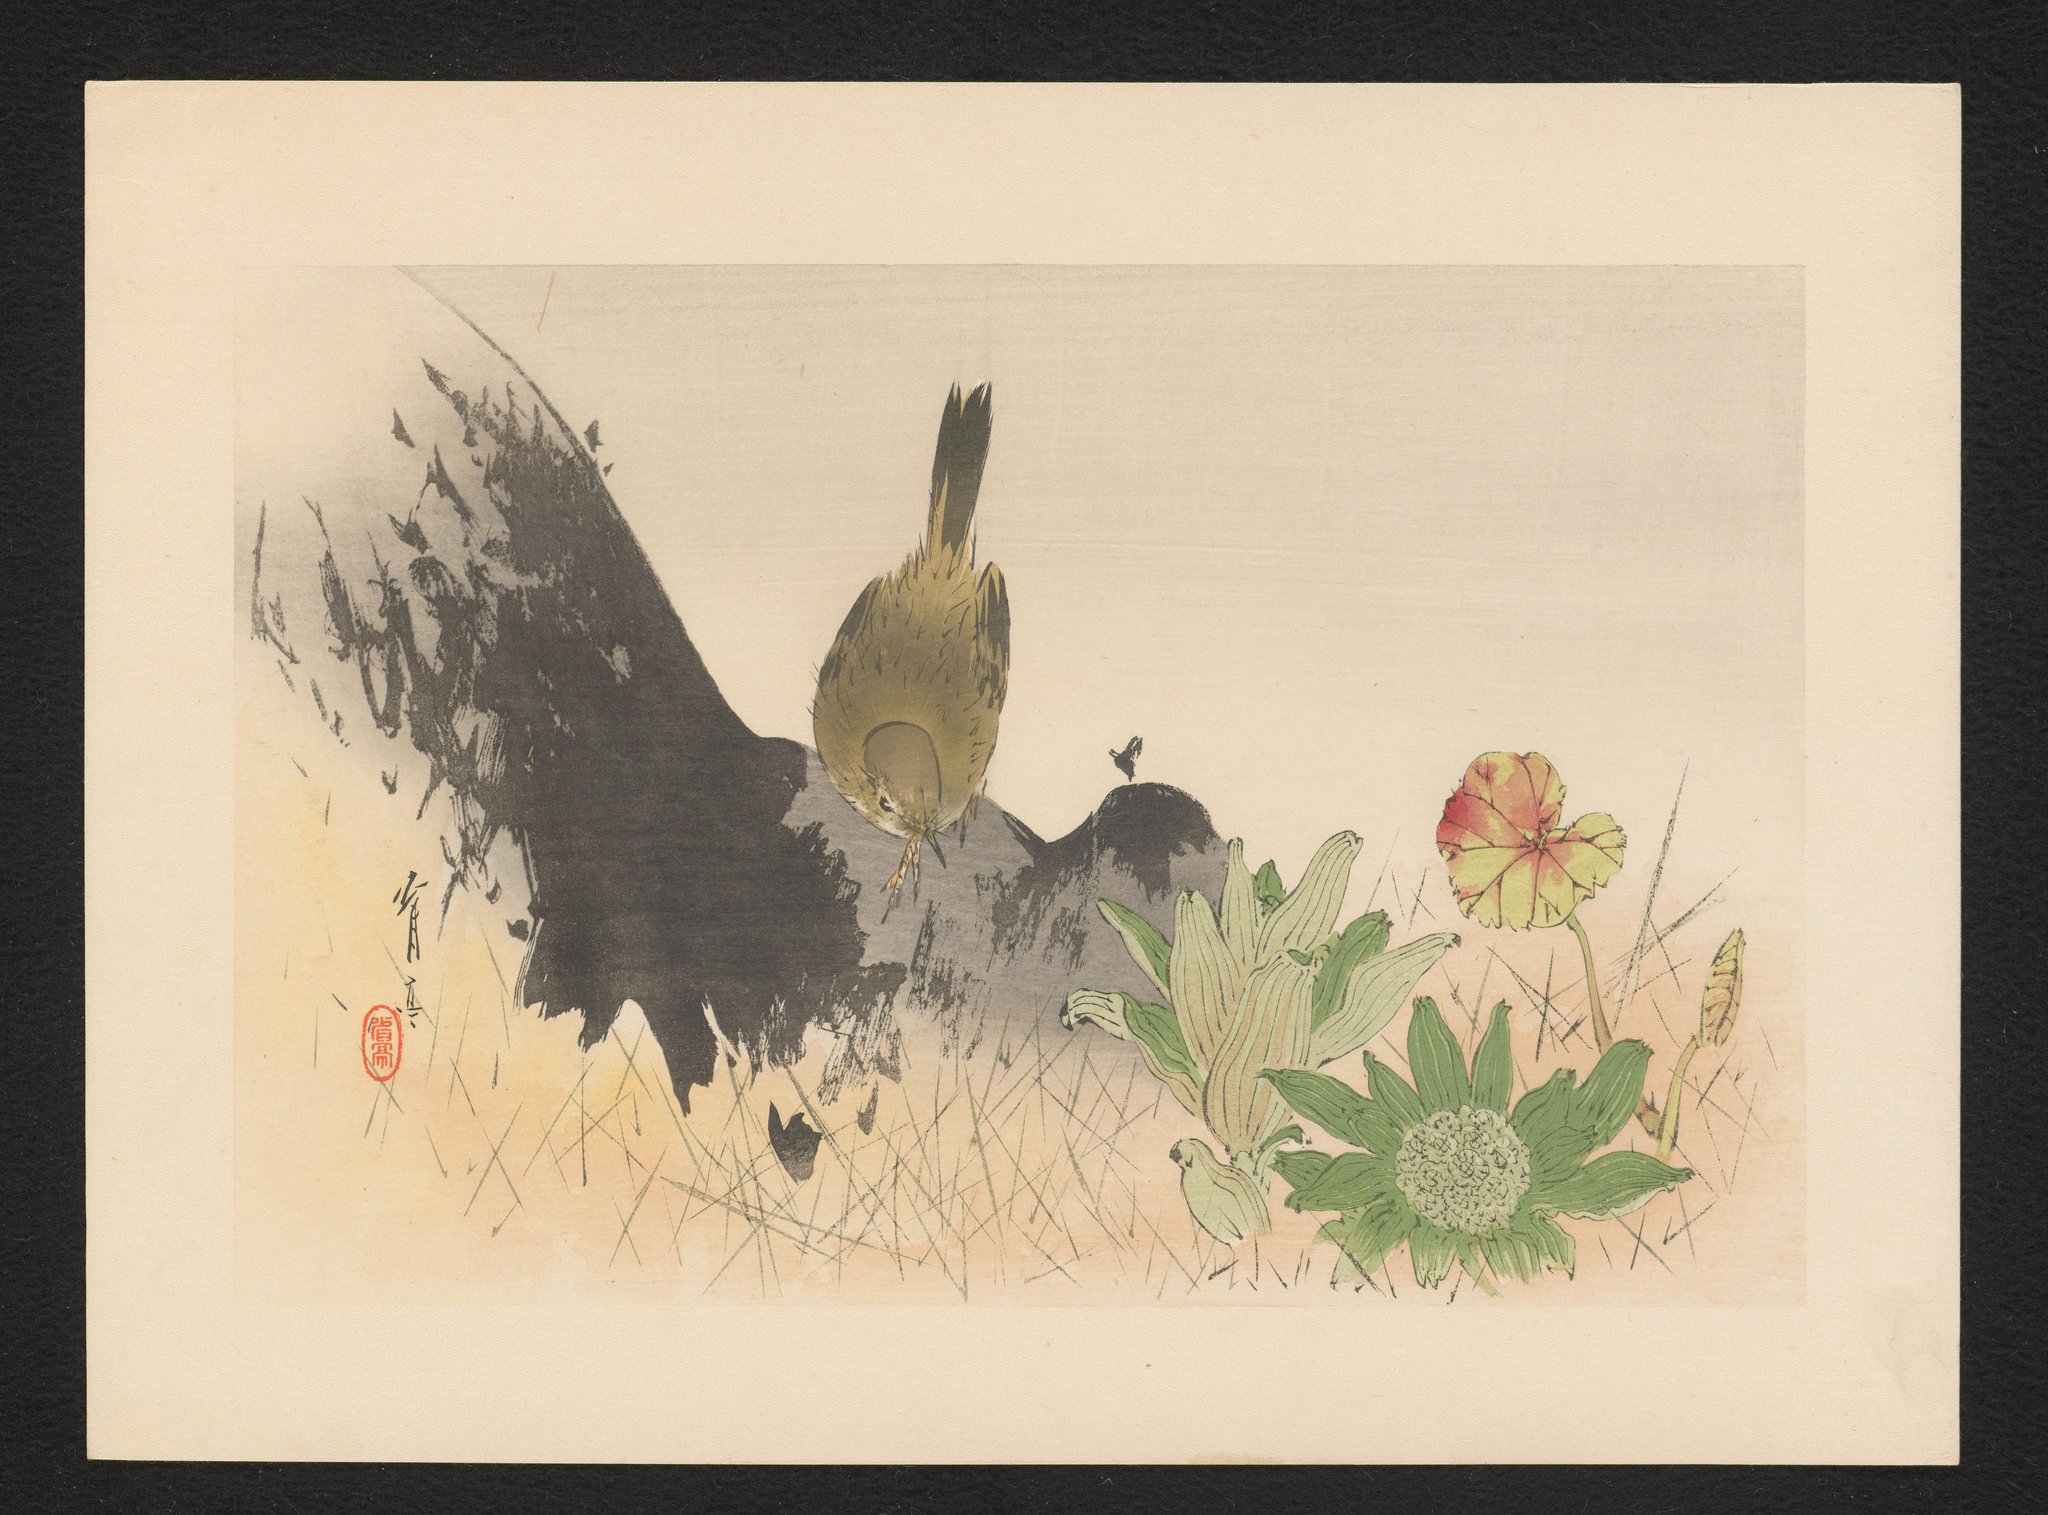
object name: print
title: Seitei kacho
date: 1916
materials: paper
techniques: woodcut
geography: tokyo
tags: birds